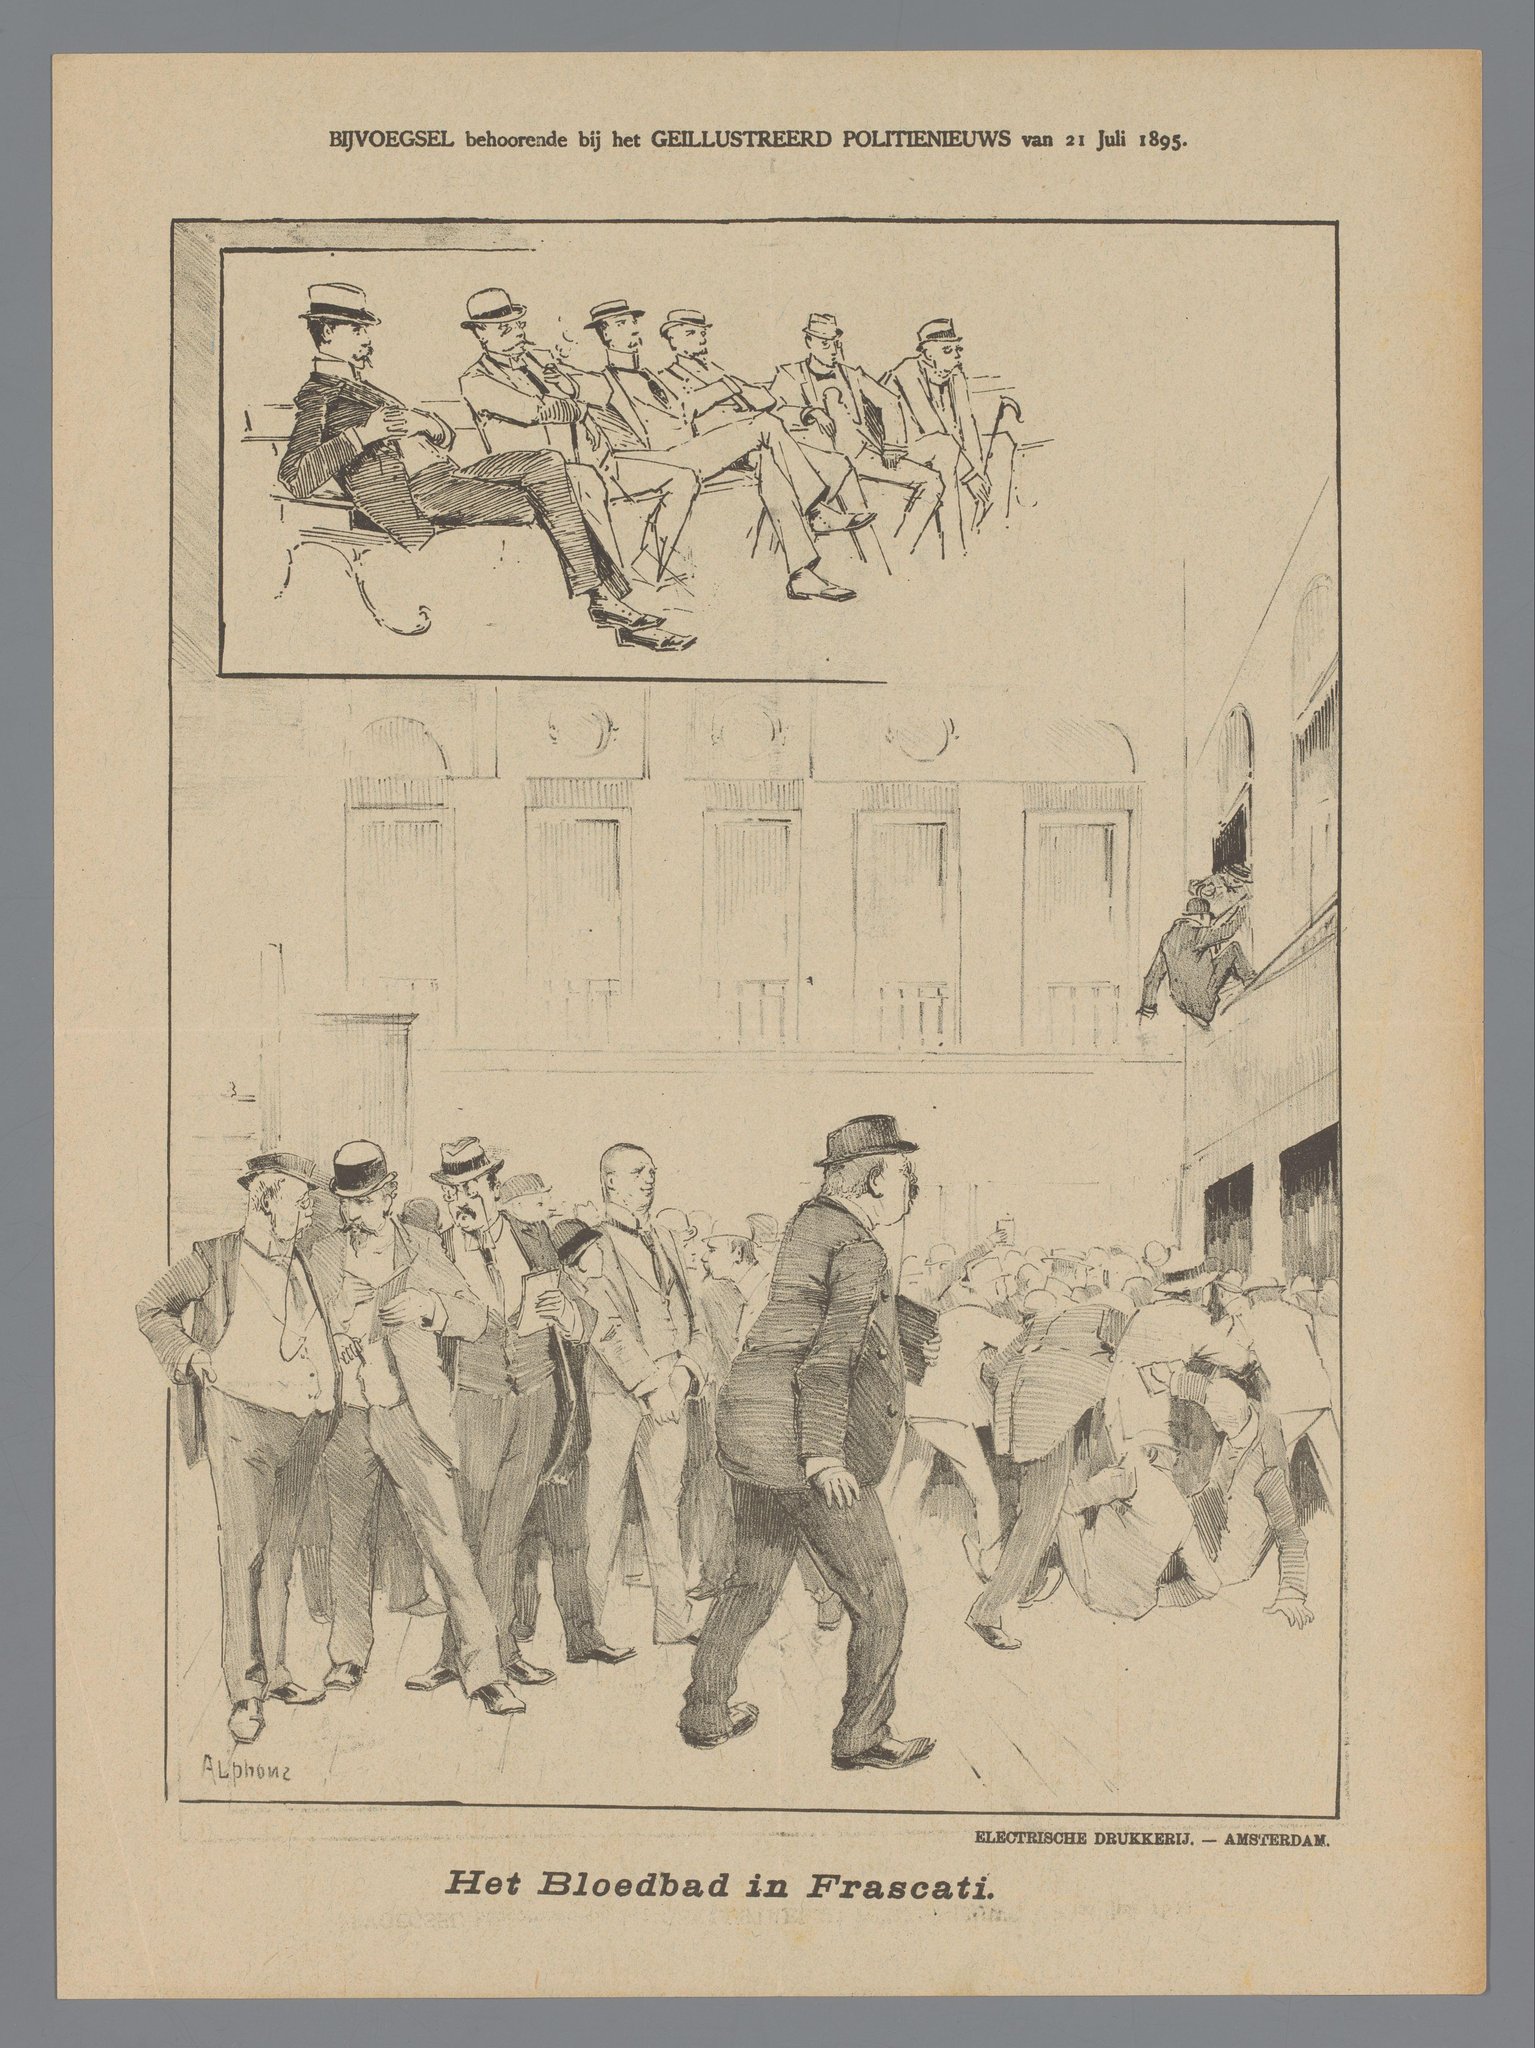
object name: cartoon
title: Het bloedbad in Frascati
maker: alphons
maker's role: print maker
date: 1895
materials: paper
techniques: printing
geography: amsterdam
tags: political caricatures and satires, netherlands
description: Spotprent uit het "Geillustreerd Politie Nieuws". Gesigneerd: op de prent. Gedateerd: boven.